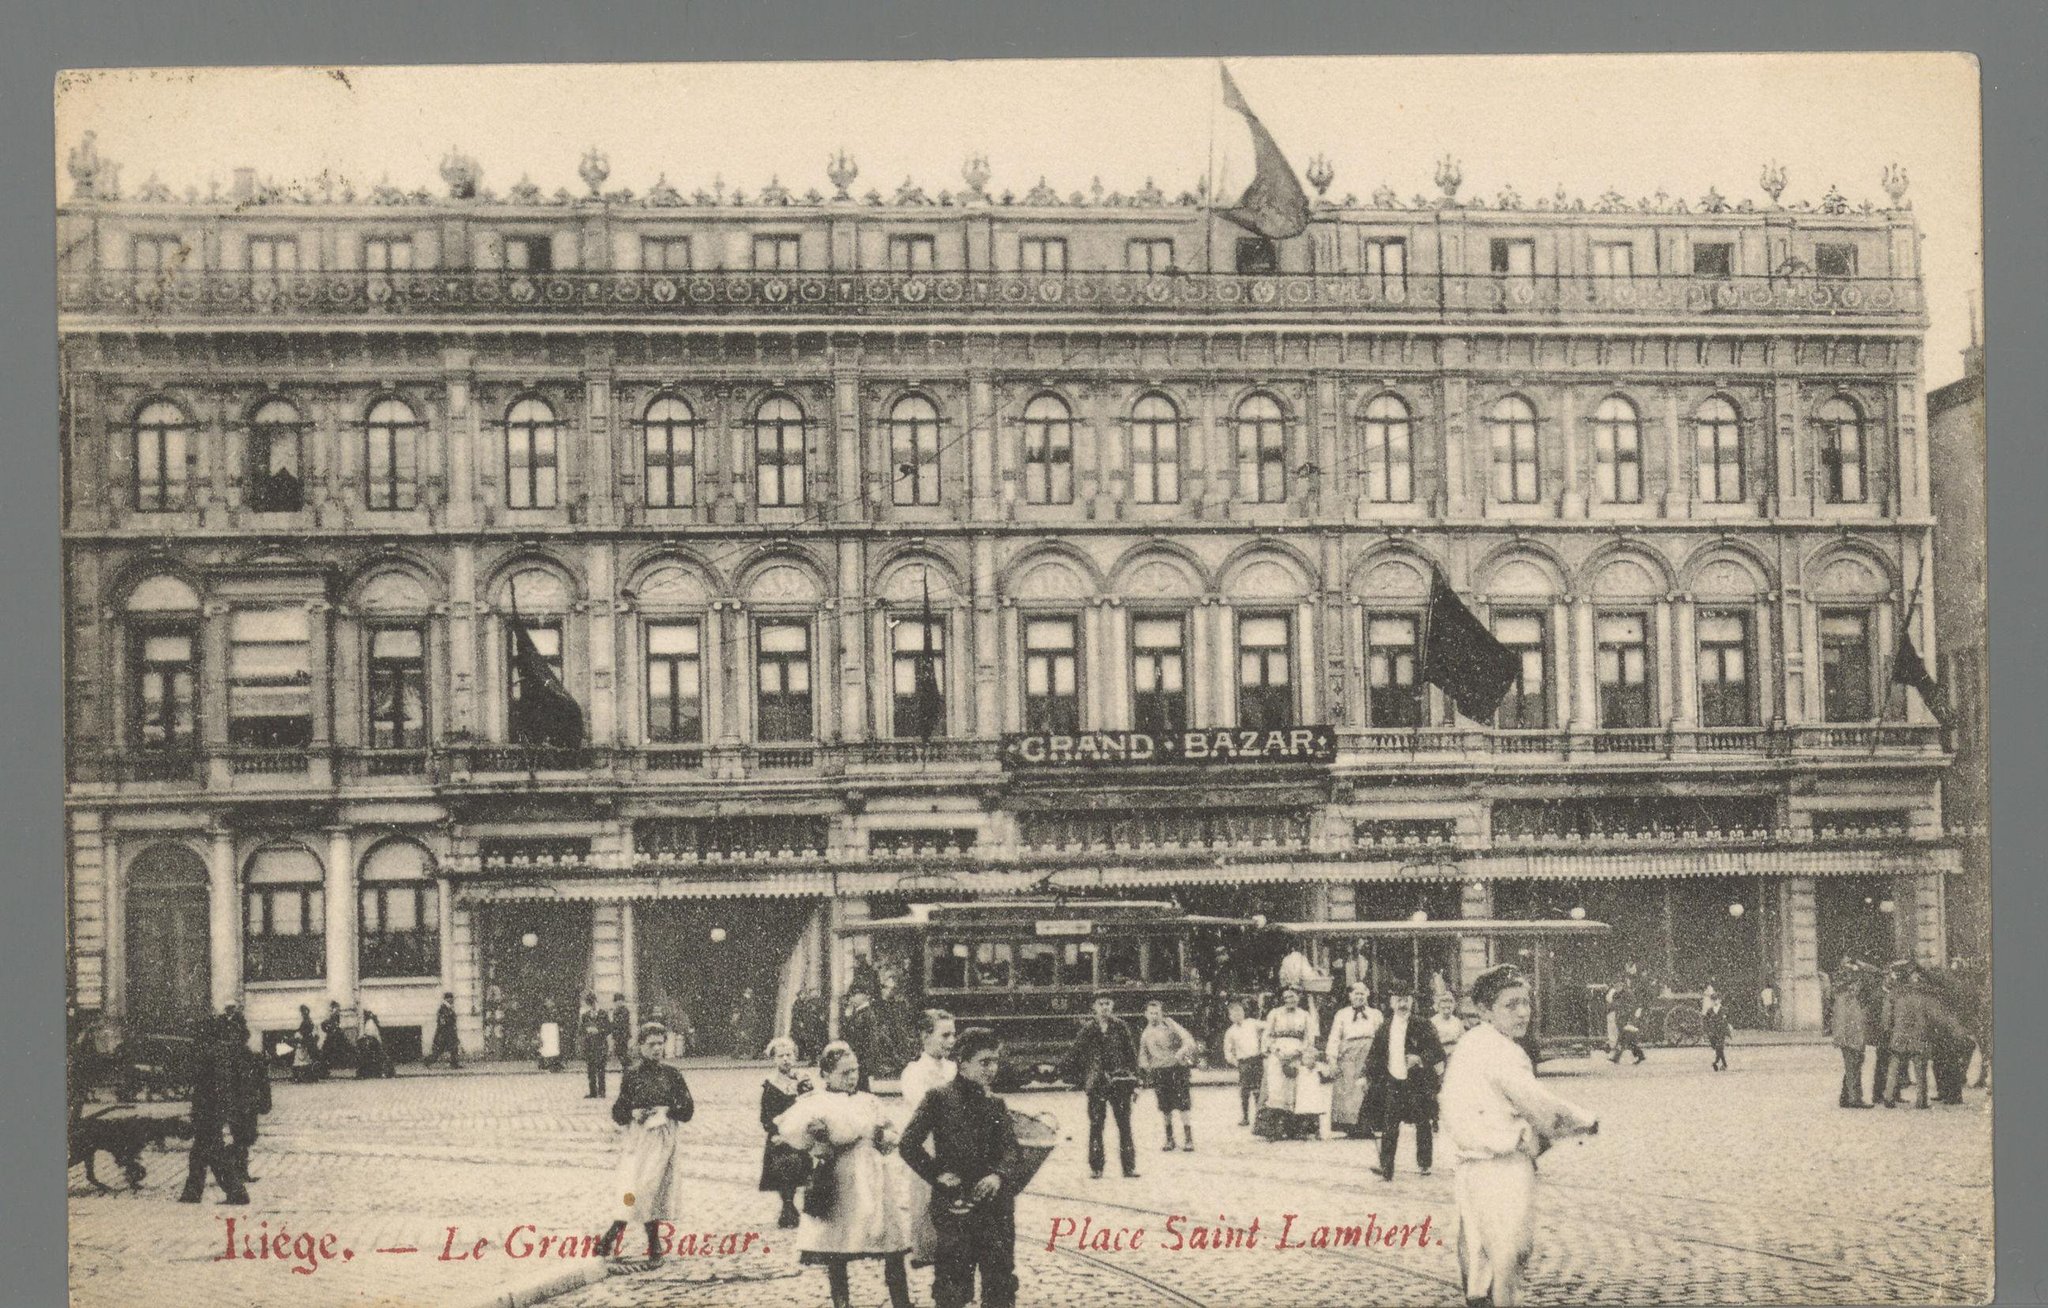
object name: ansichtkaart, prentbriefkaart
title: Liège. Le Grand Bazar. Place Saint-Lambert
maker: Anonymous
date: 1906-1930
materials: cardboard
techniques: photograph, writing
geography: liège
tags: square, place, circus, etc. (+ city(-scape) with figures, staffage), edifice, e.g.: public building, department store, liège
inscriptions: postage stamp